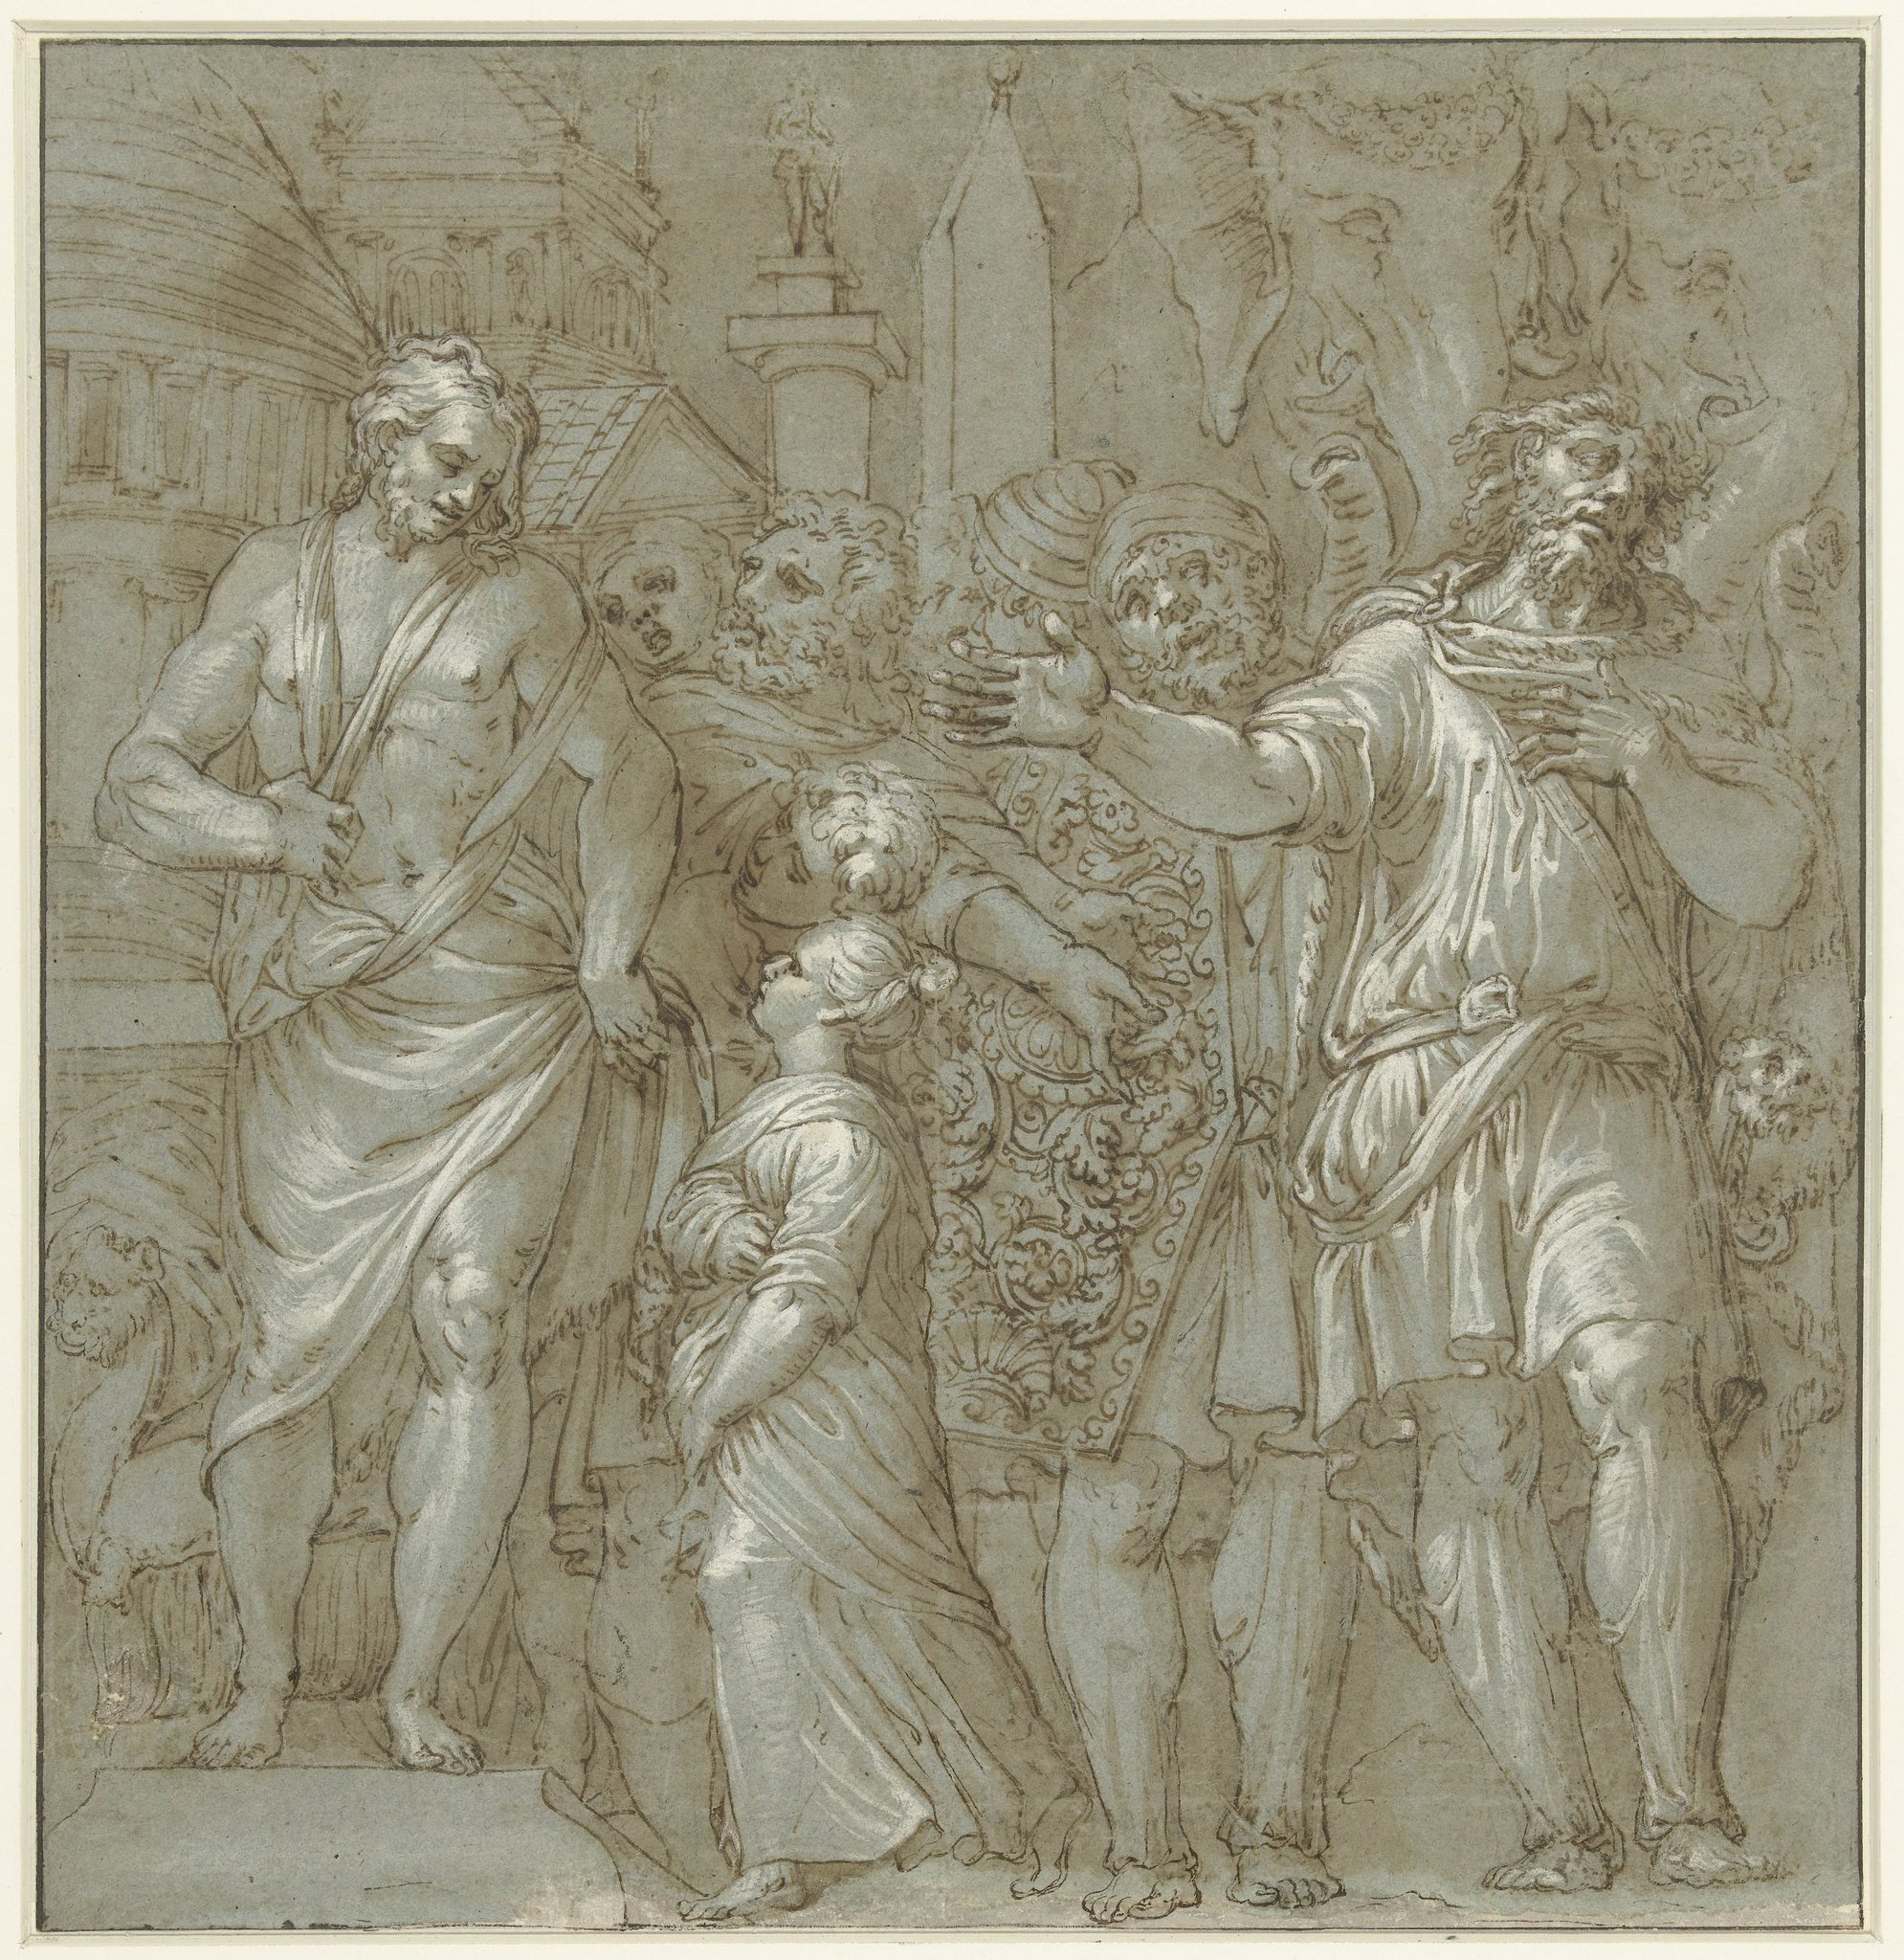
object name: drawing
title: Onbevreesdheid van Caius Fabricius Luscinus na de overwinning van Pyrrhus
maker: Anonymous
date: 1510-1600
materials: ink, paper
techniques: brush, pen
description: De onbevreesdheid van de Romeinse consul Caius Fabricius Luscinus na de overwinning van Pyrrhus. Mannen, vrouwen en olifanten.